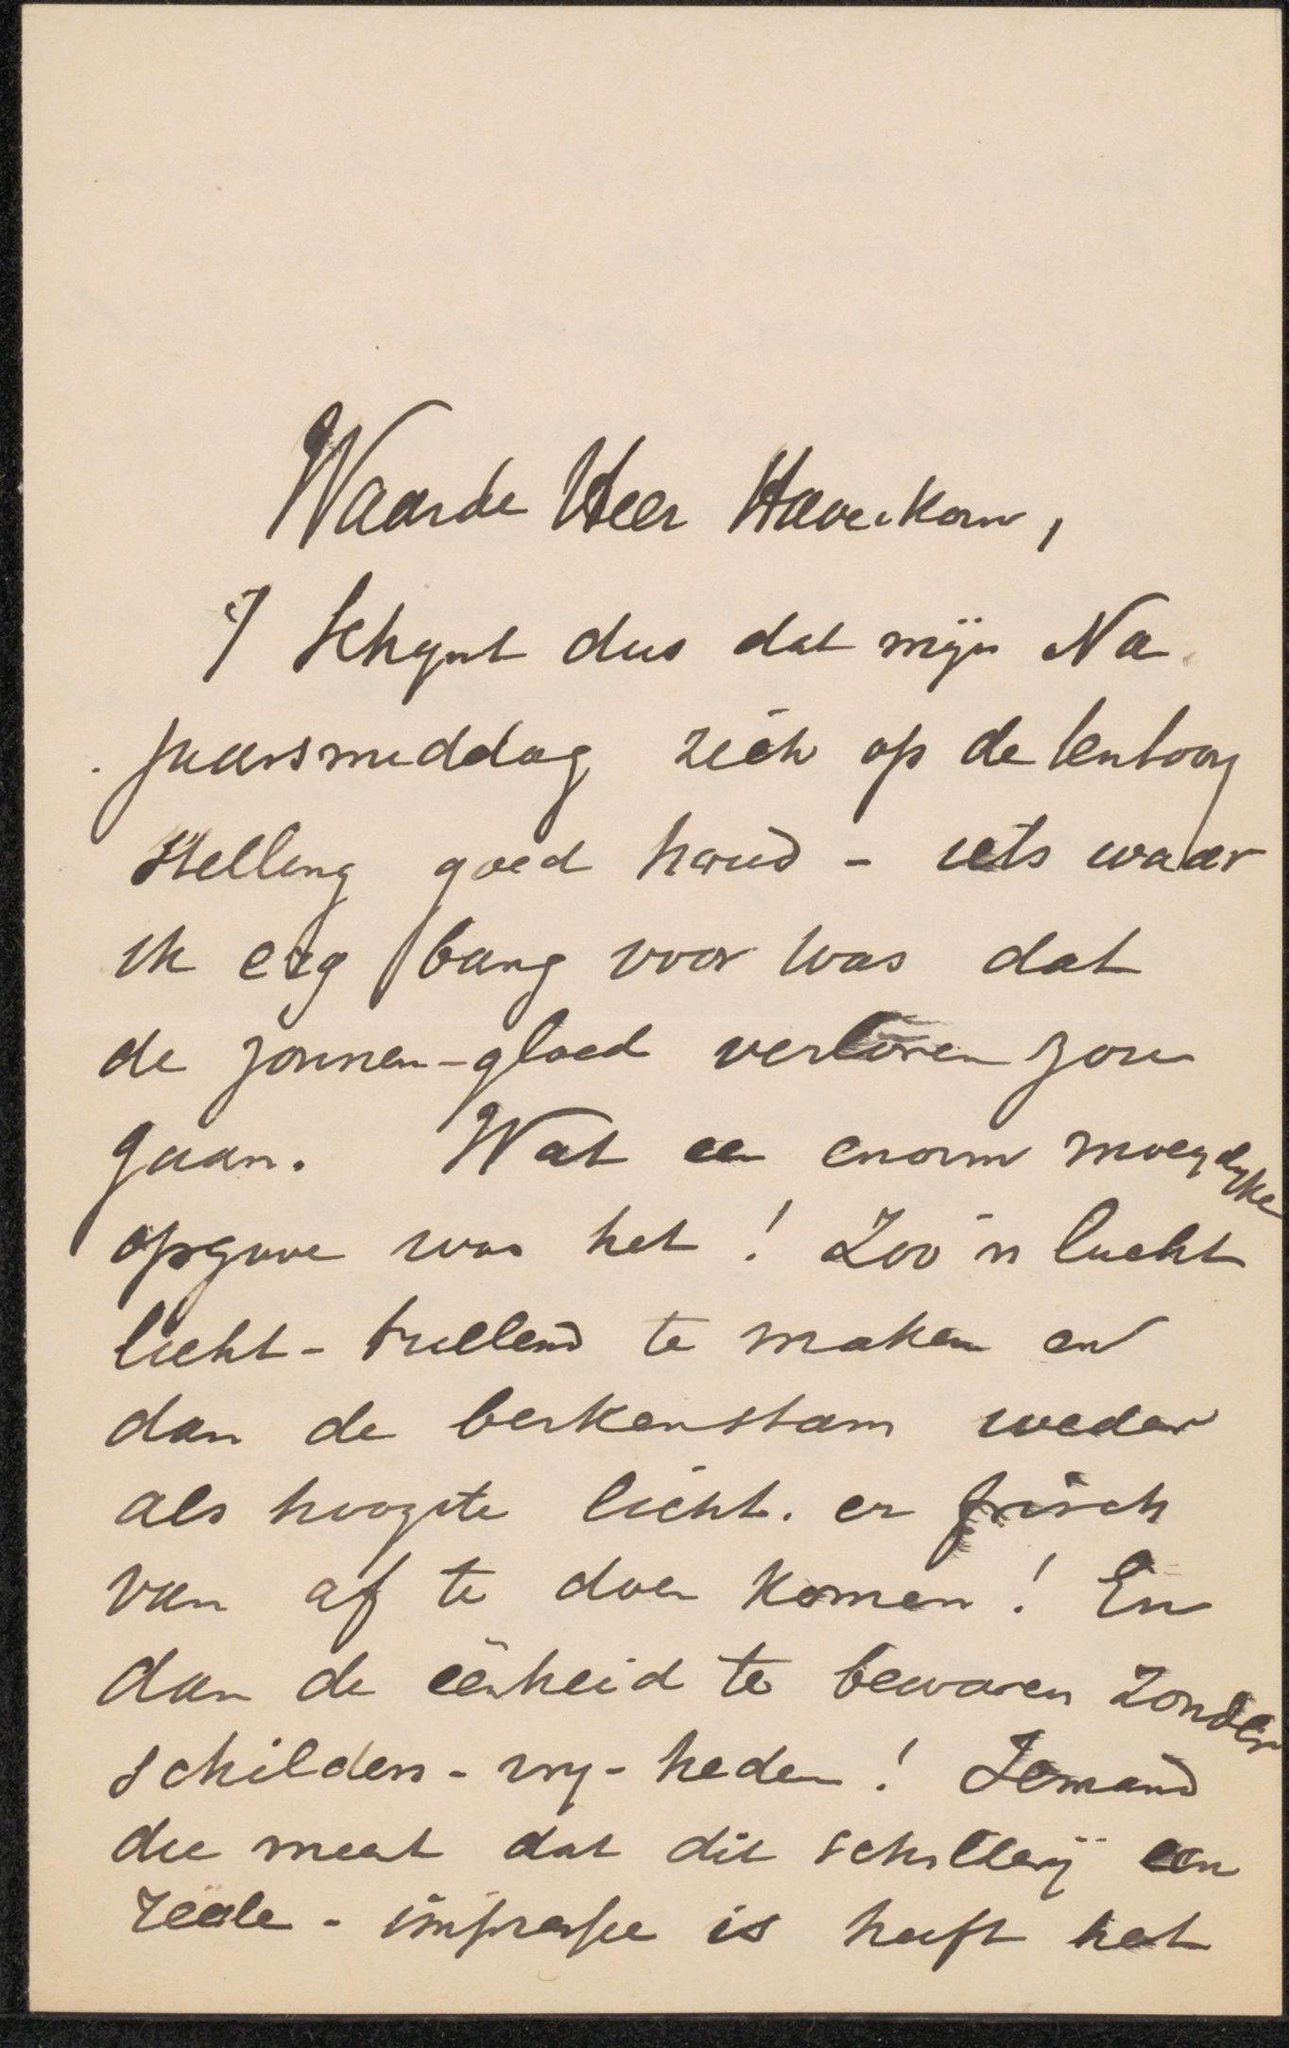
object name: letter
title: Brief aan Pieter Haverkorn van Rijsewijk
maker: théophile de bock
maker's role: draughtsman, painter, print maker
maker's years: 1851-1904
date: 1898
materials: ink, paper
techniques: pen, writing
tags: pieter haverkorn van rijsewijk, family life, painting (including book-illumination, miniature-painting), exhibition ~ art, art collecting, money, rotterdam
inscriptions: collector's mark: ‘RPK’